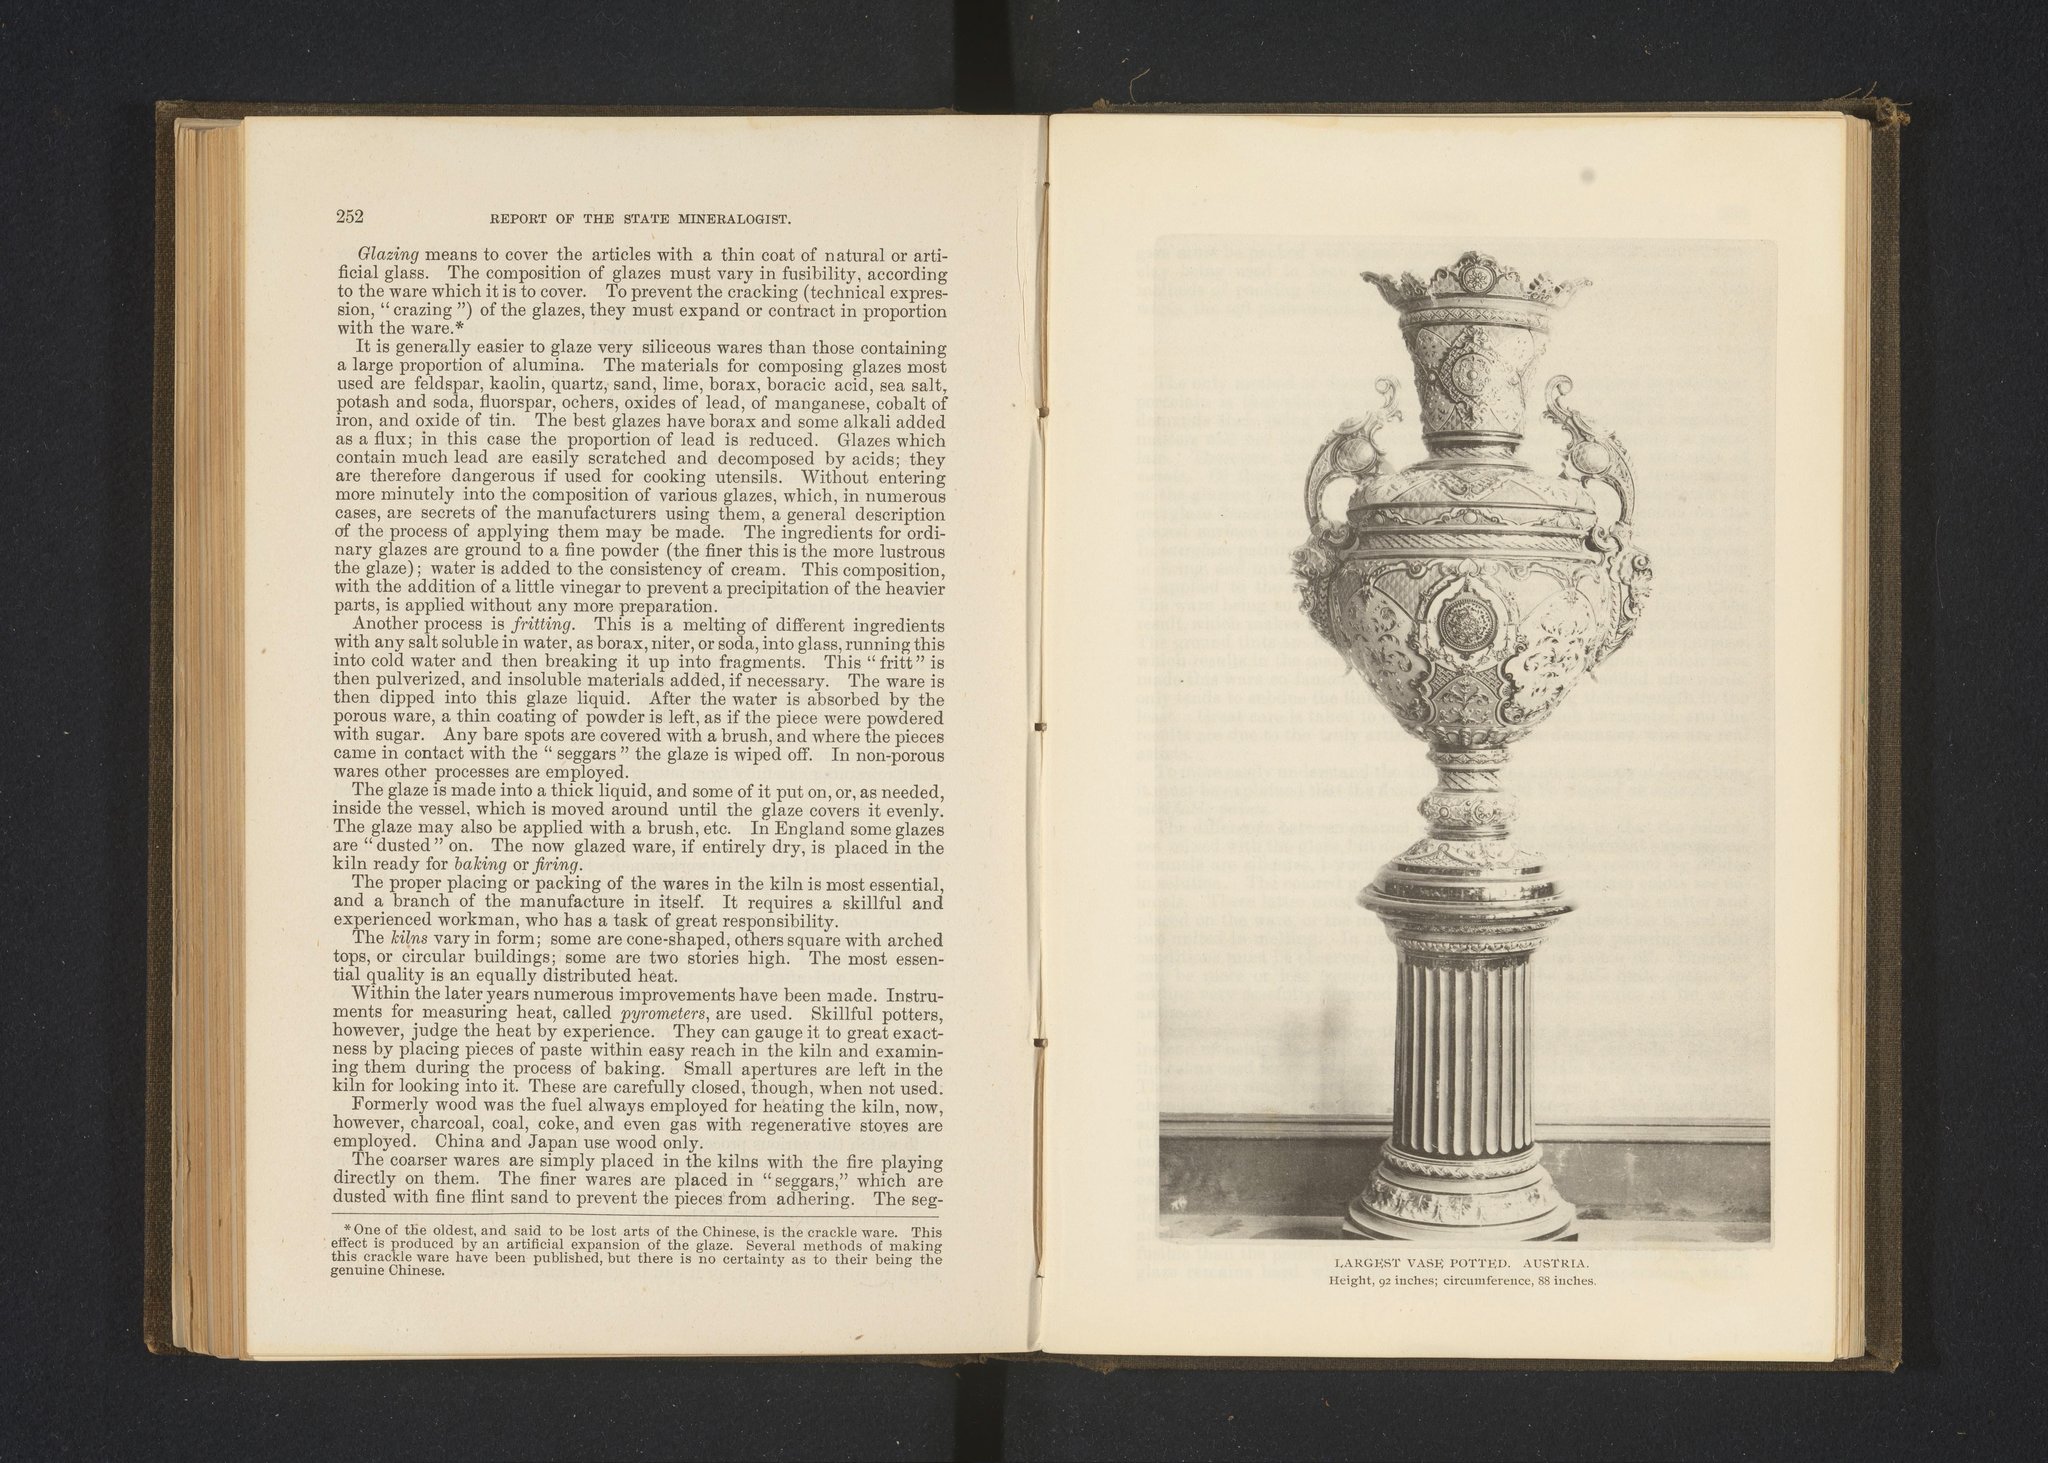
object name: page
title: Largest Vase Potted. Austria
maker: Anonymous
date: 1885-1890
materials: paper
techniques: photograph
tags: vase ~ ornament, pedestal of a piece of sculpture (perhaps in the form of a herm)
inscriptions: inscription: ‘Height, 92 inches; circumference, 88 inches.’